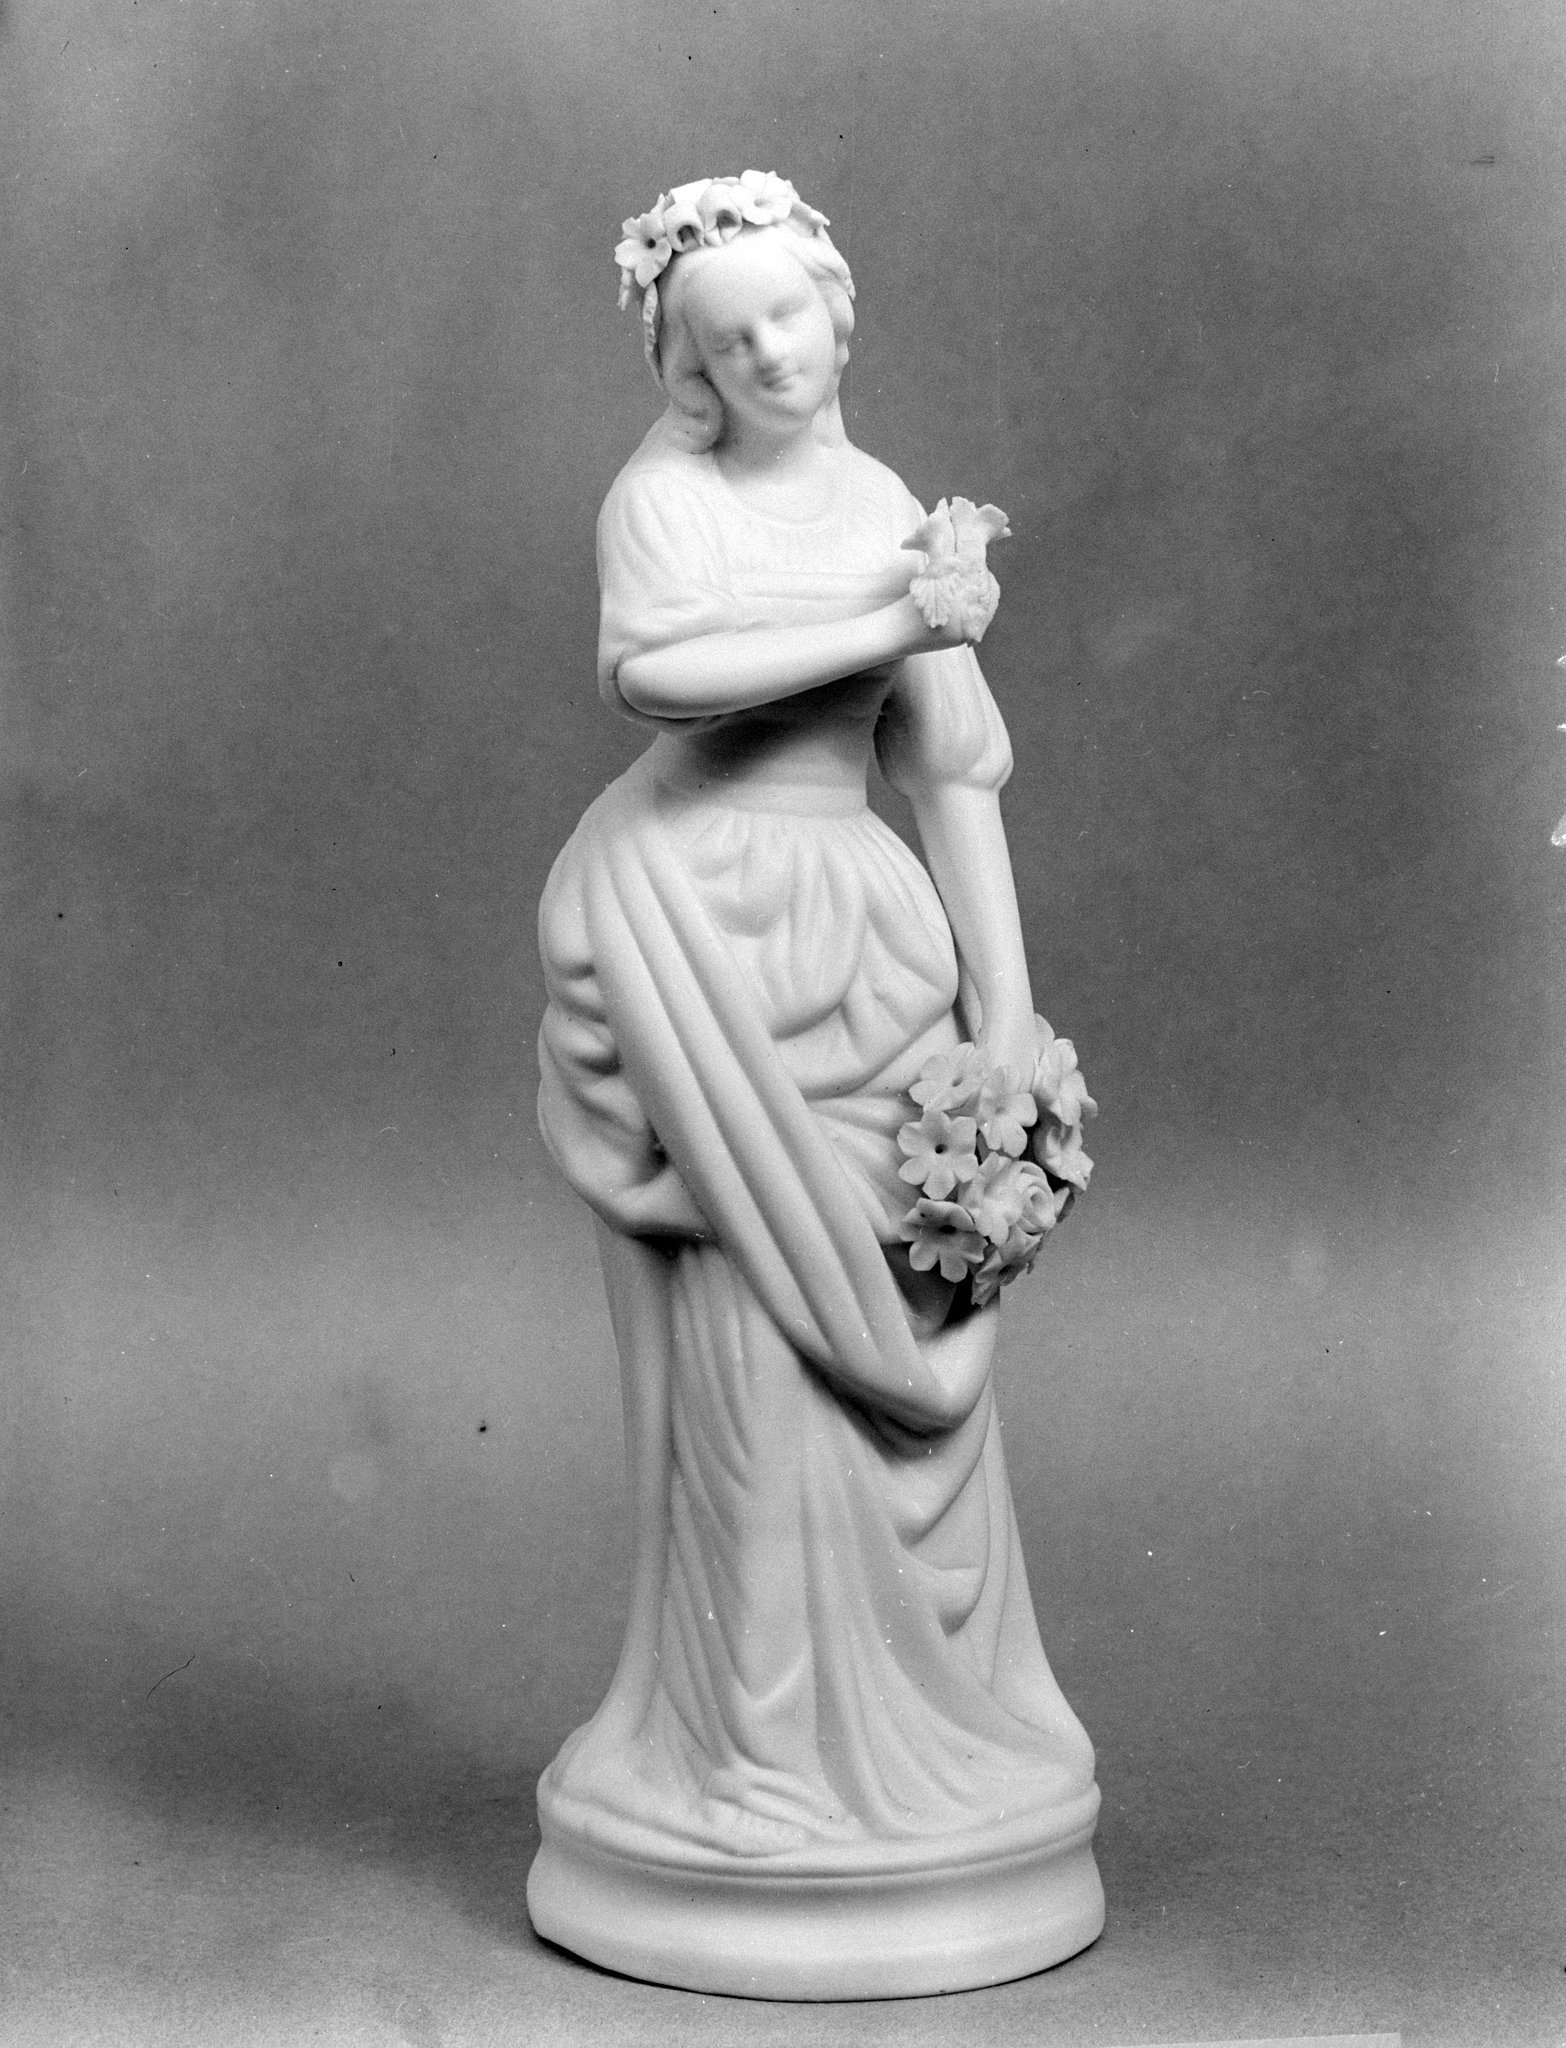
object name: figure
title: Female Figure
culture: american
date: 1830-1870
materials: porcelain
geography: united states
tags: women